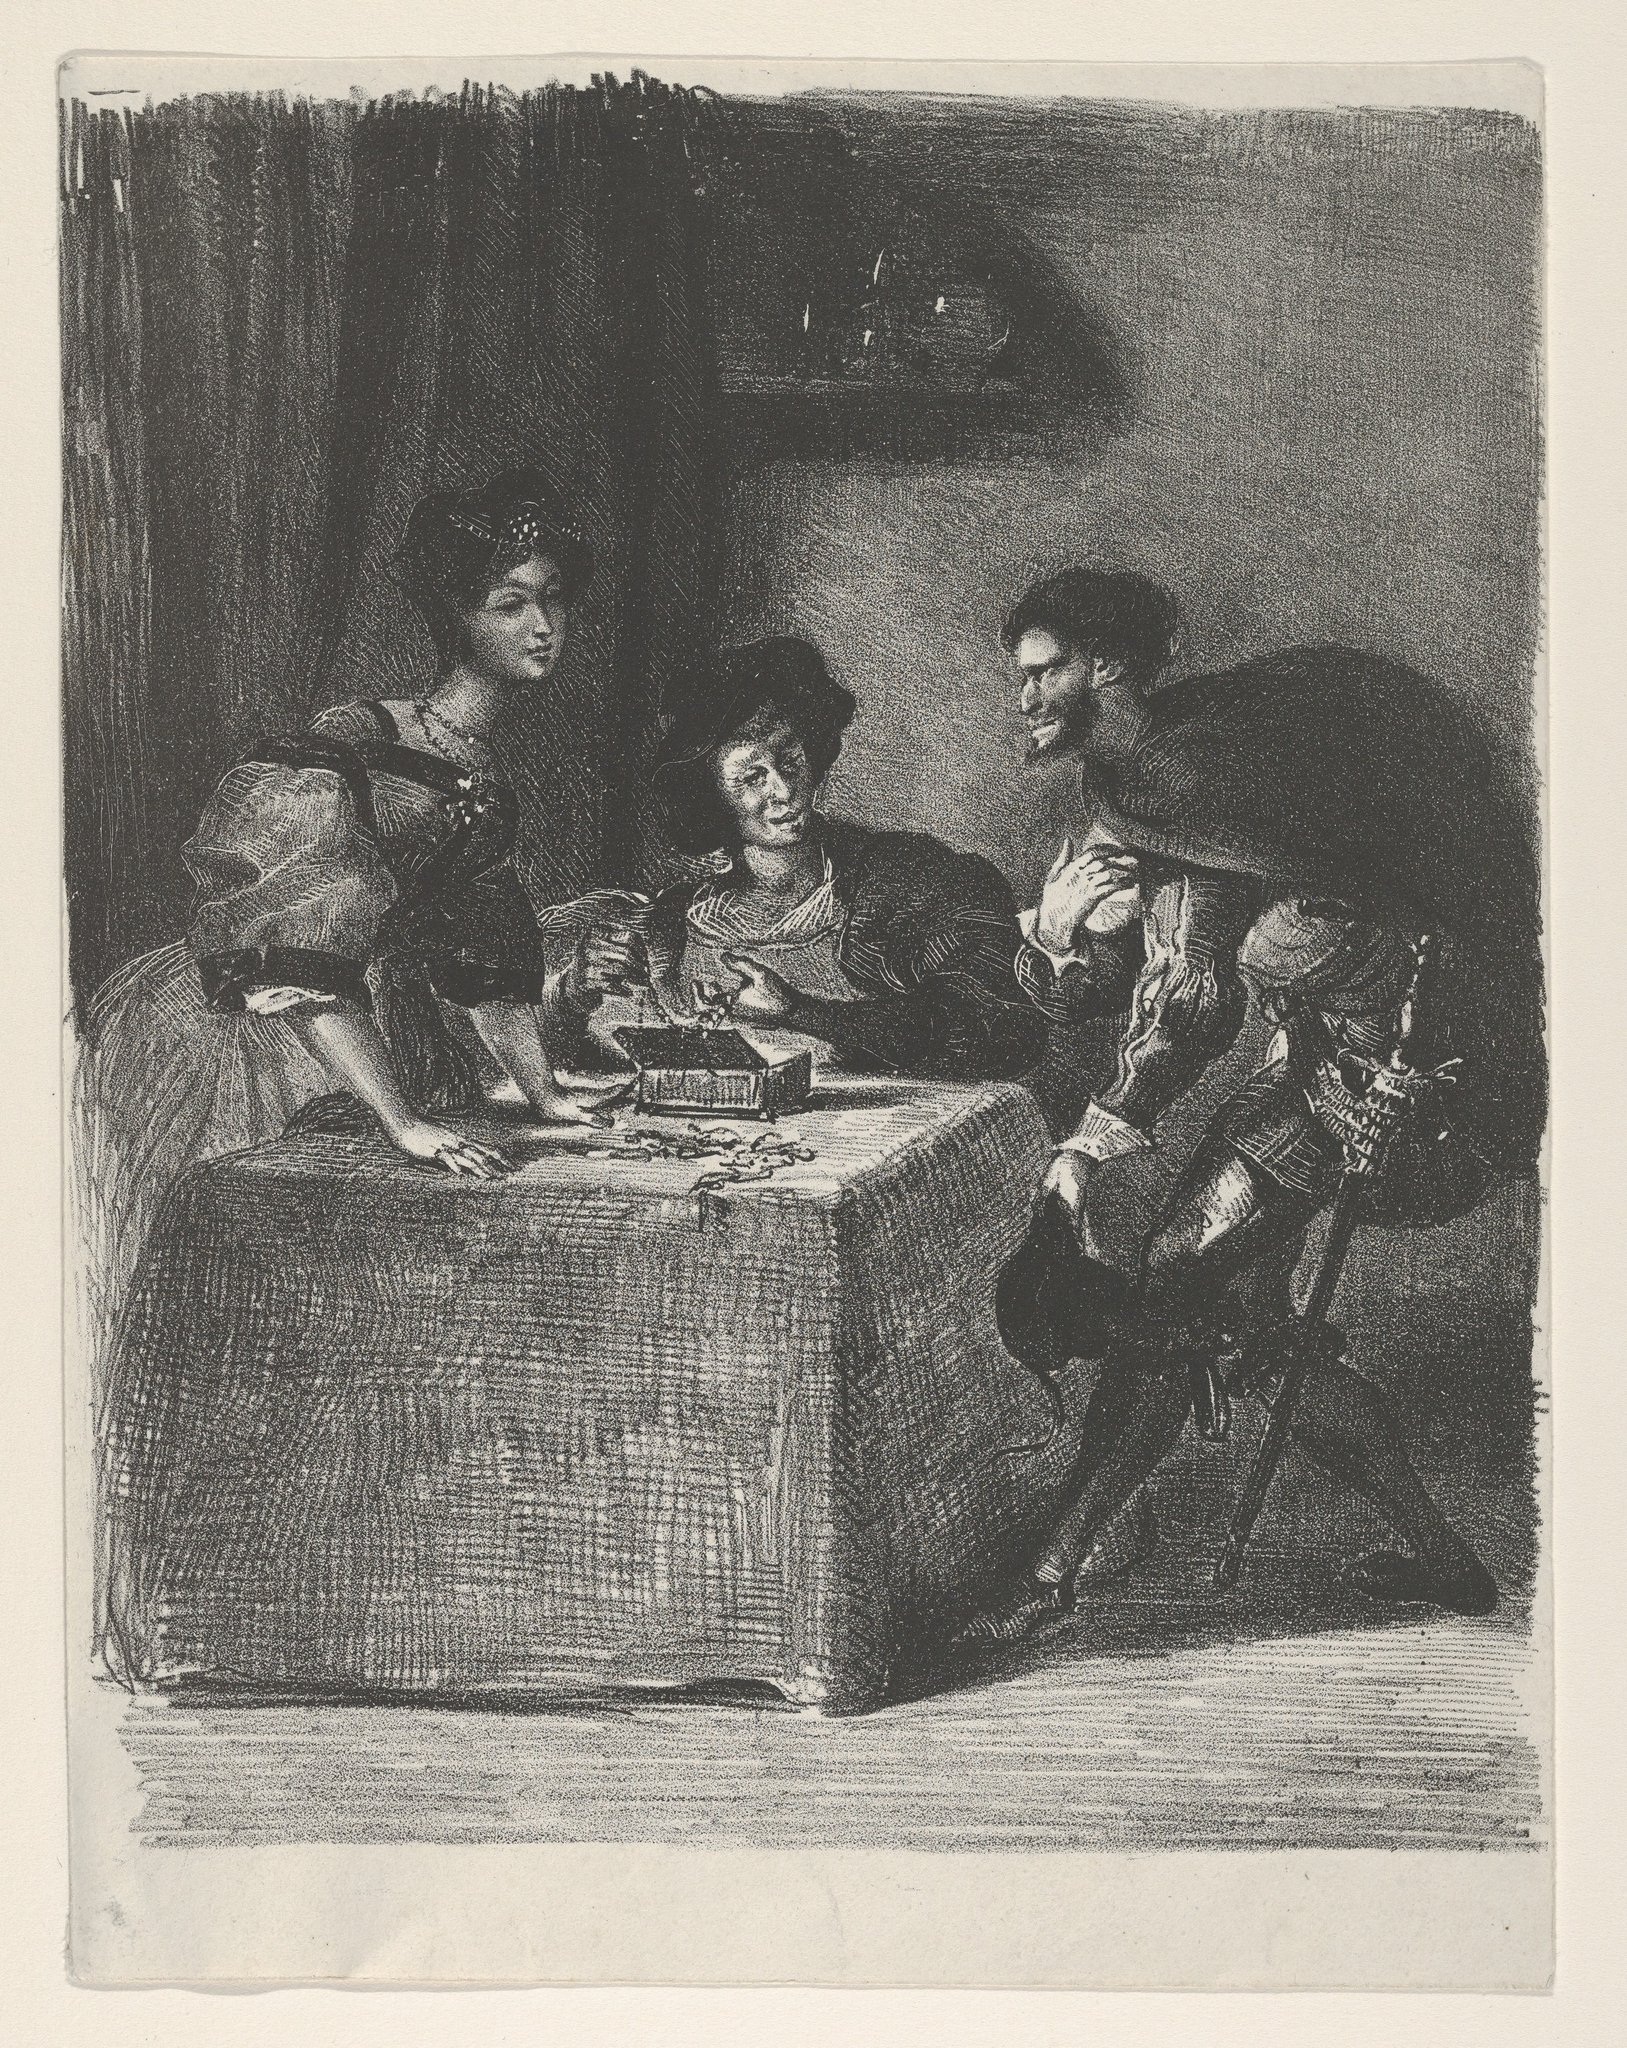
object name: print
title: Mephistopheles presents himself to Martha (Goethe, Faust)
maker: eugène delacroix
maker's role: artist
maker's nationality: french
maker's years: 1798-1863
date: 1825-1827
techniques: lithograph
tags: men,women